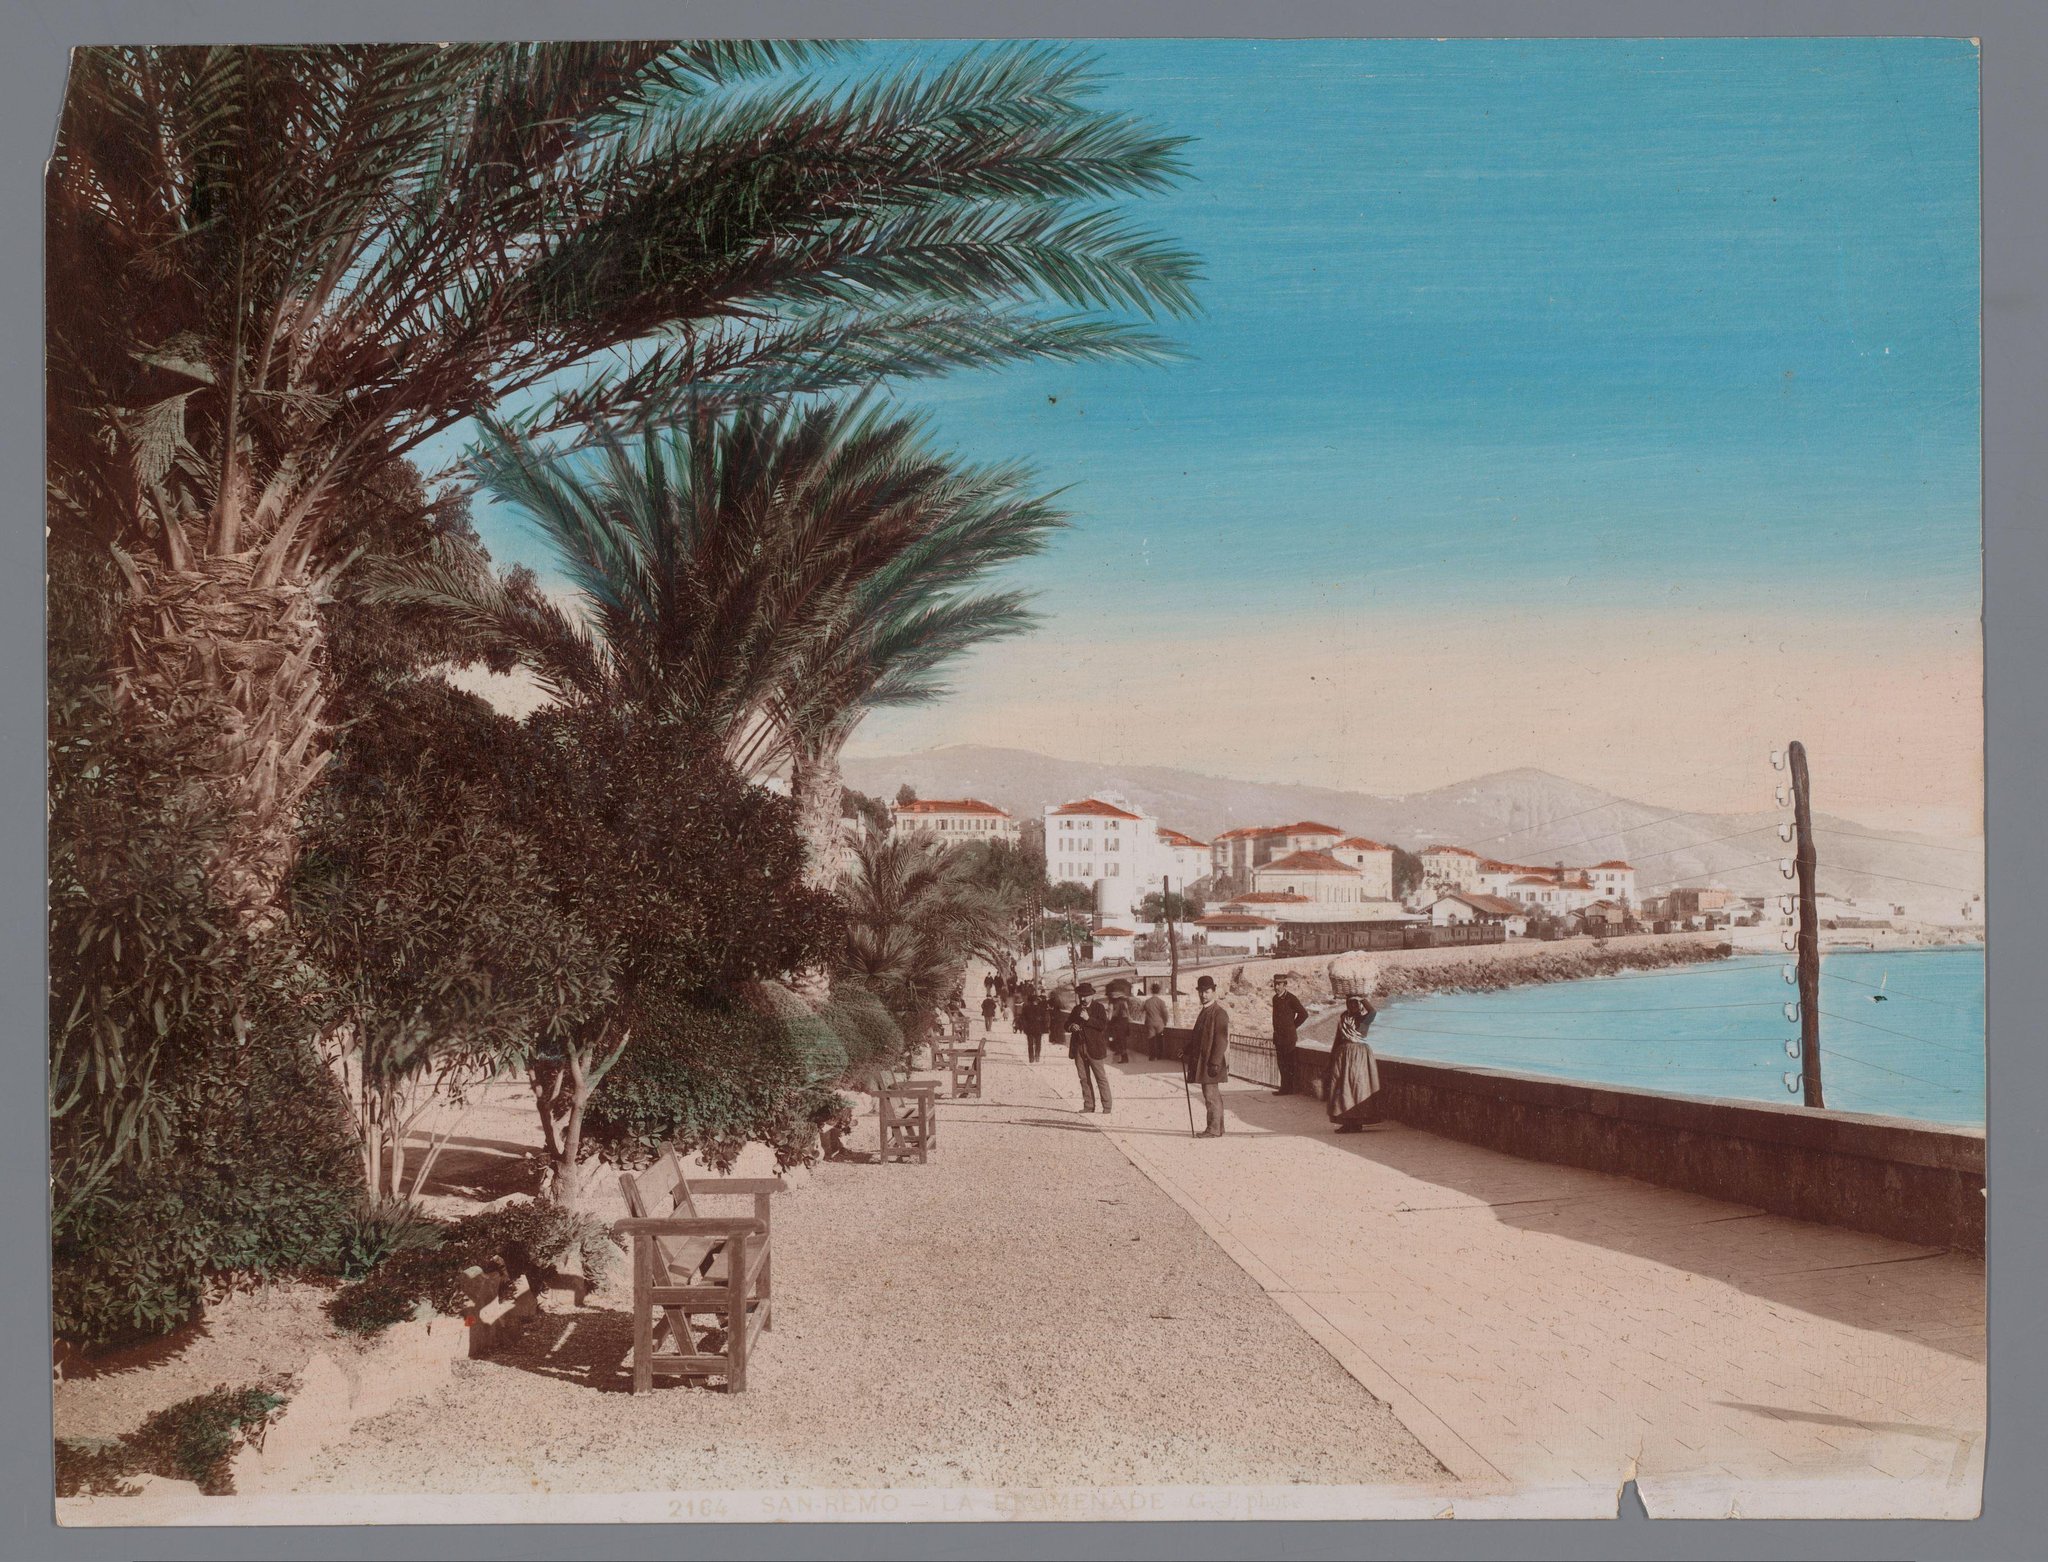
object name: photograph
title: Promenade te San Remo, Italië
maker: Anonymous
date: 1880-1910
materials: cardboard, photographic support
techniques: hand coloring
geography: san remo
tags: trees: palm-tree, quay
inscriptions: number: ‘2184’